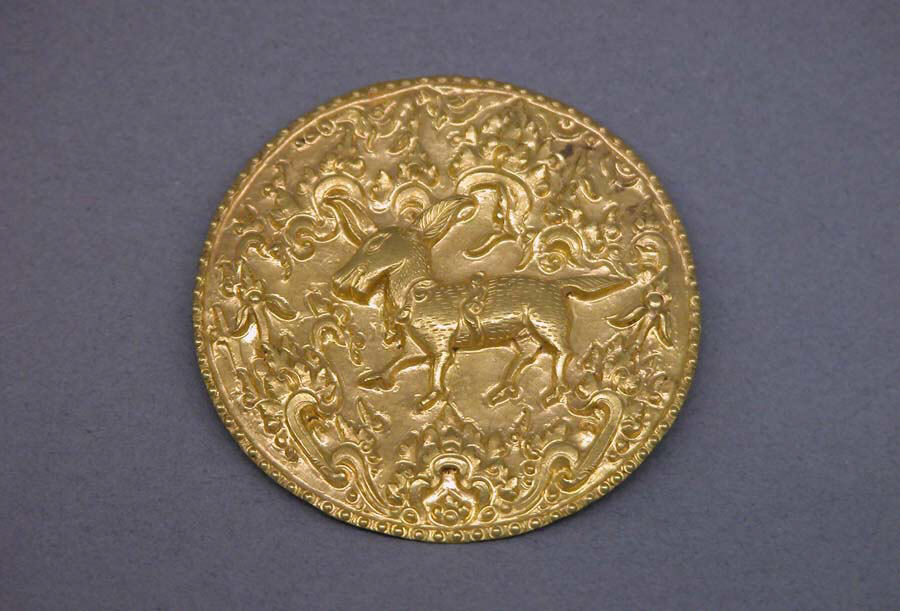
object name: disk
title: Disk or Subang Cover with Deer Surrounded by Foliate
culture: indonesian, javanese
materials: gold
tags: deer